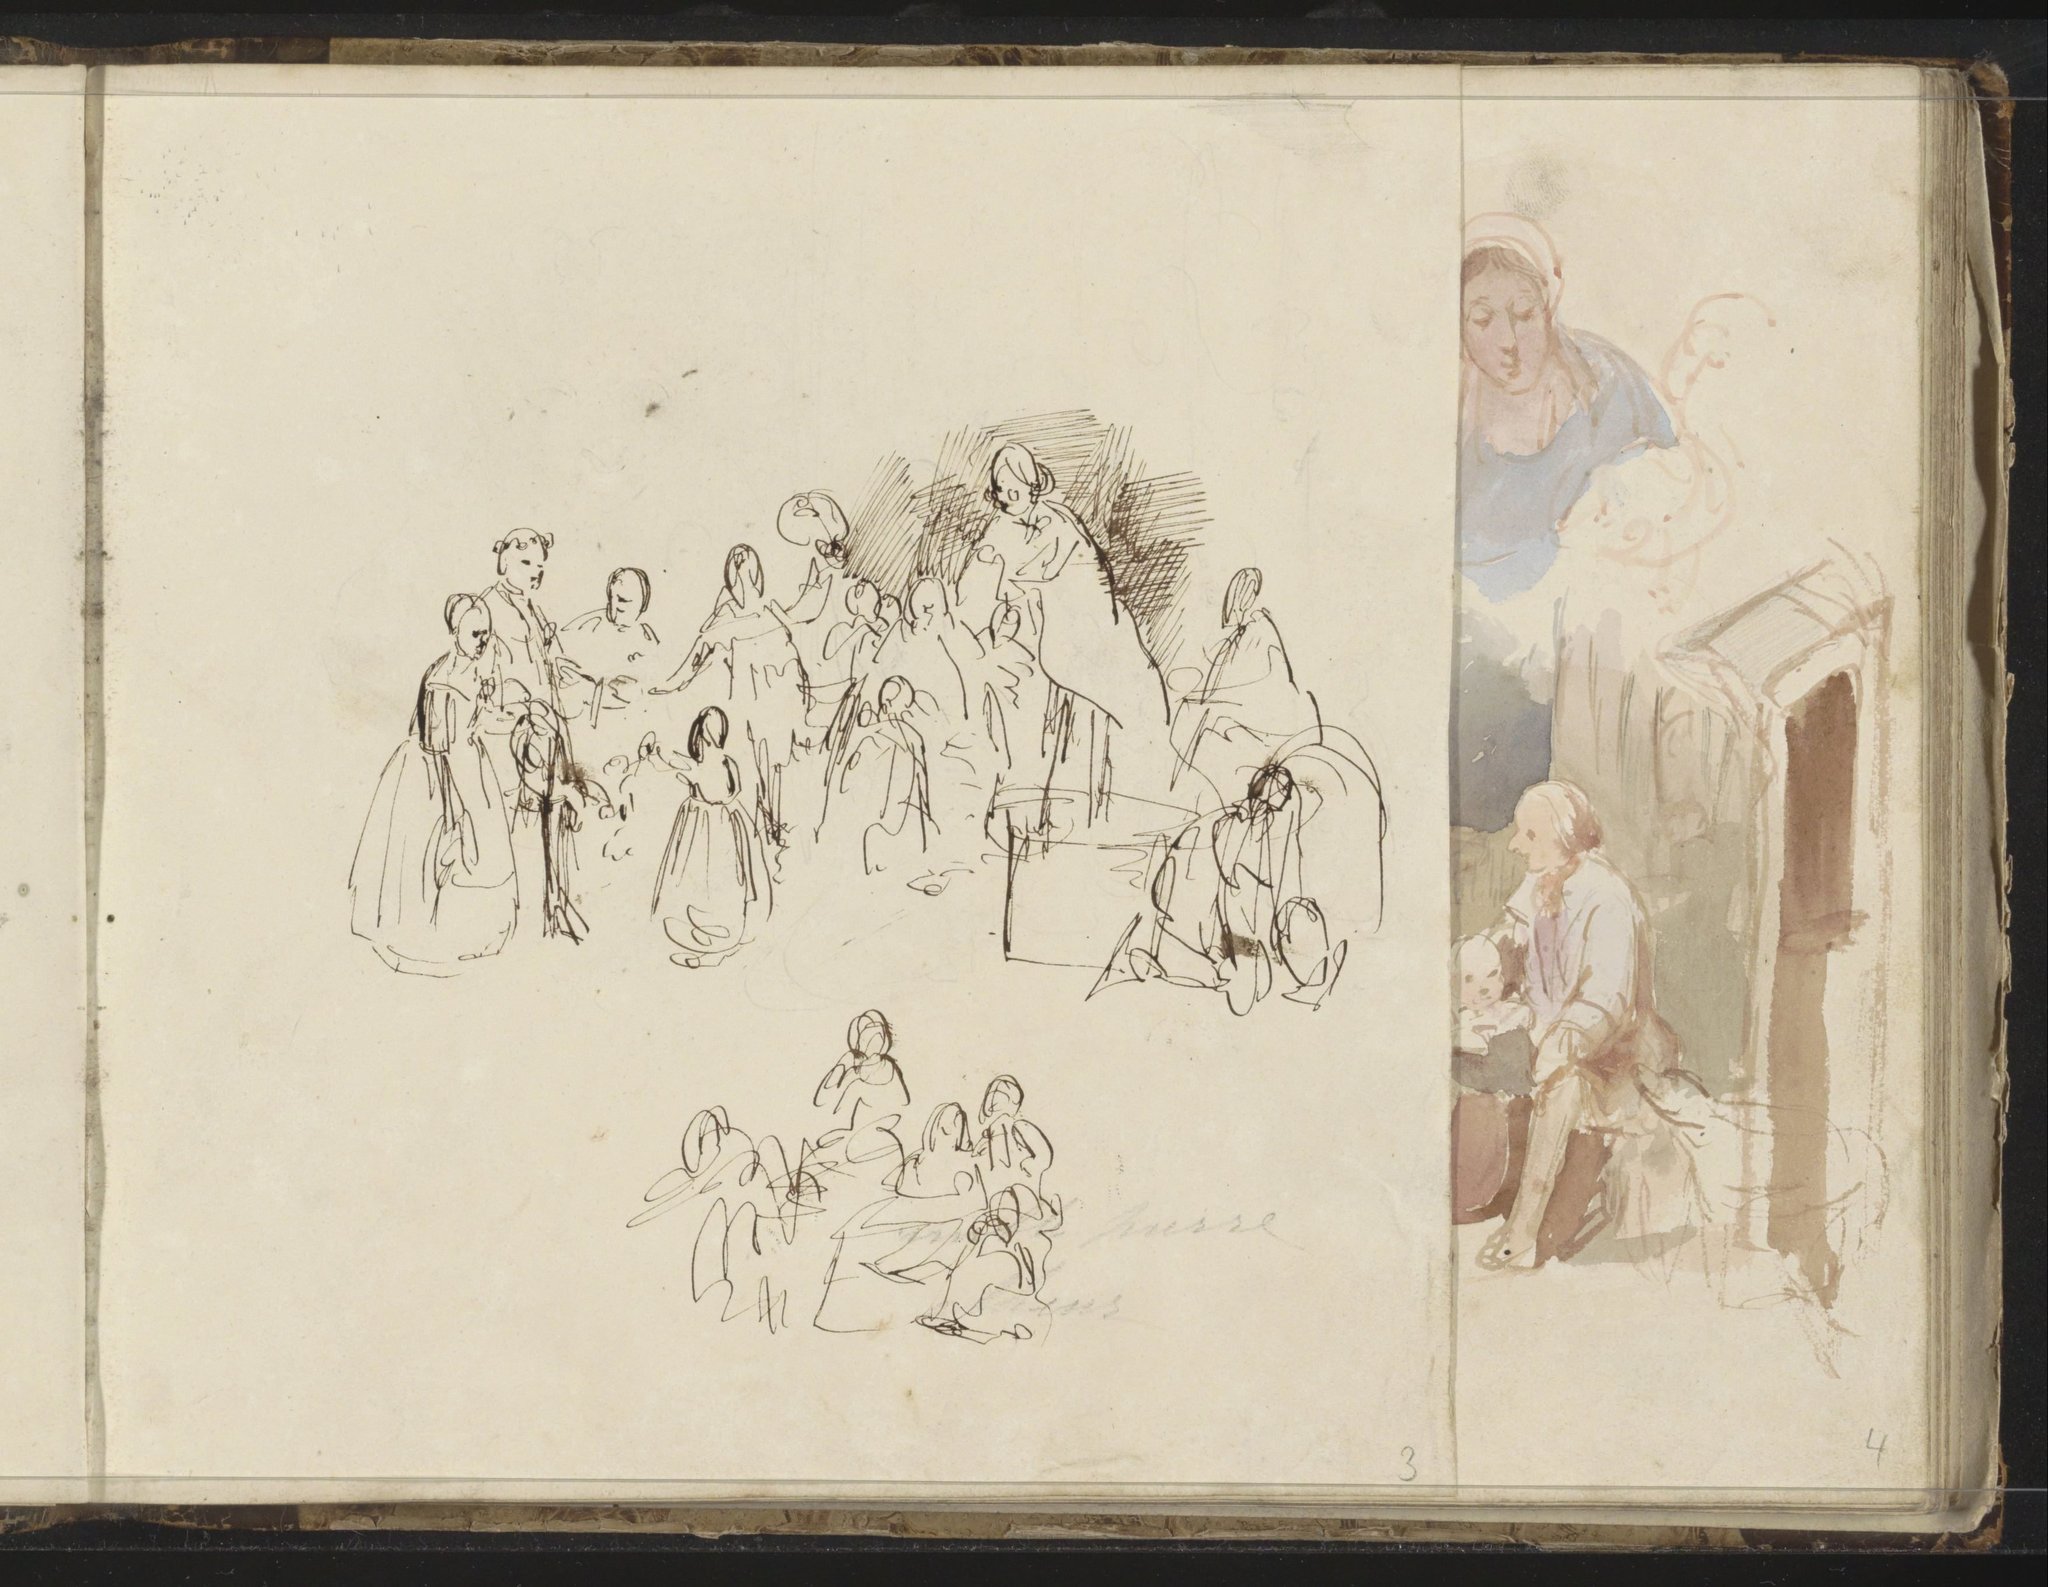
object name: sketchbook leaf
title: Twee groepen mannen, vrouwen en kinderen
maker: willem hendrik schmidt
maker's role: draughtsman, painter, print maker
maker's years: 1809-1849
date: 1819-1849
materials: ink, paper, pencil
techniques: pen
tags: family group, especially parents with their child(ren)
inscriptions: annotation: ‘[...] presse/ [...]ens’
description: Het blad is deels uit het schetsboek gescheurd.